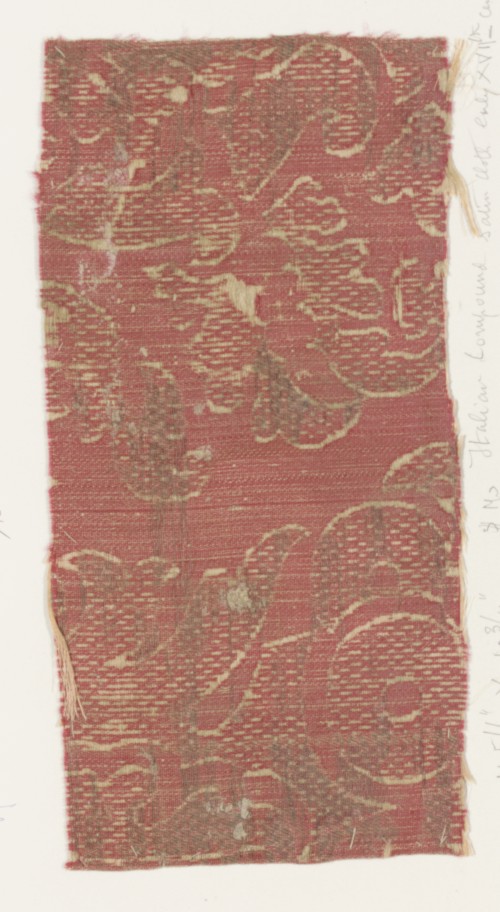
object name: fragment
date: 1601-1633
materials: metal thread, silk